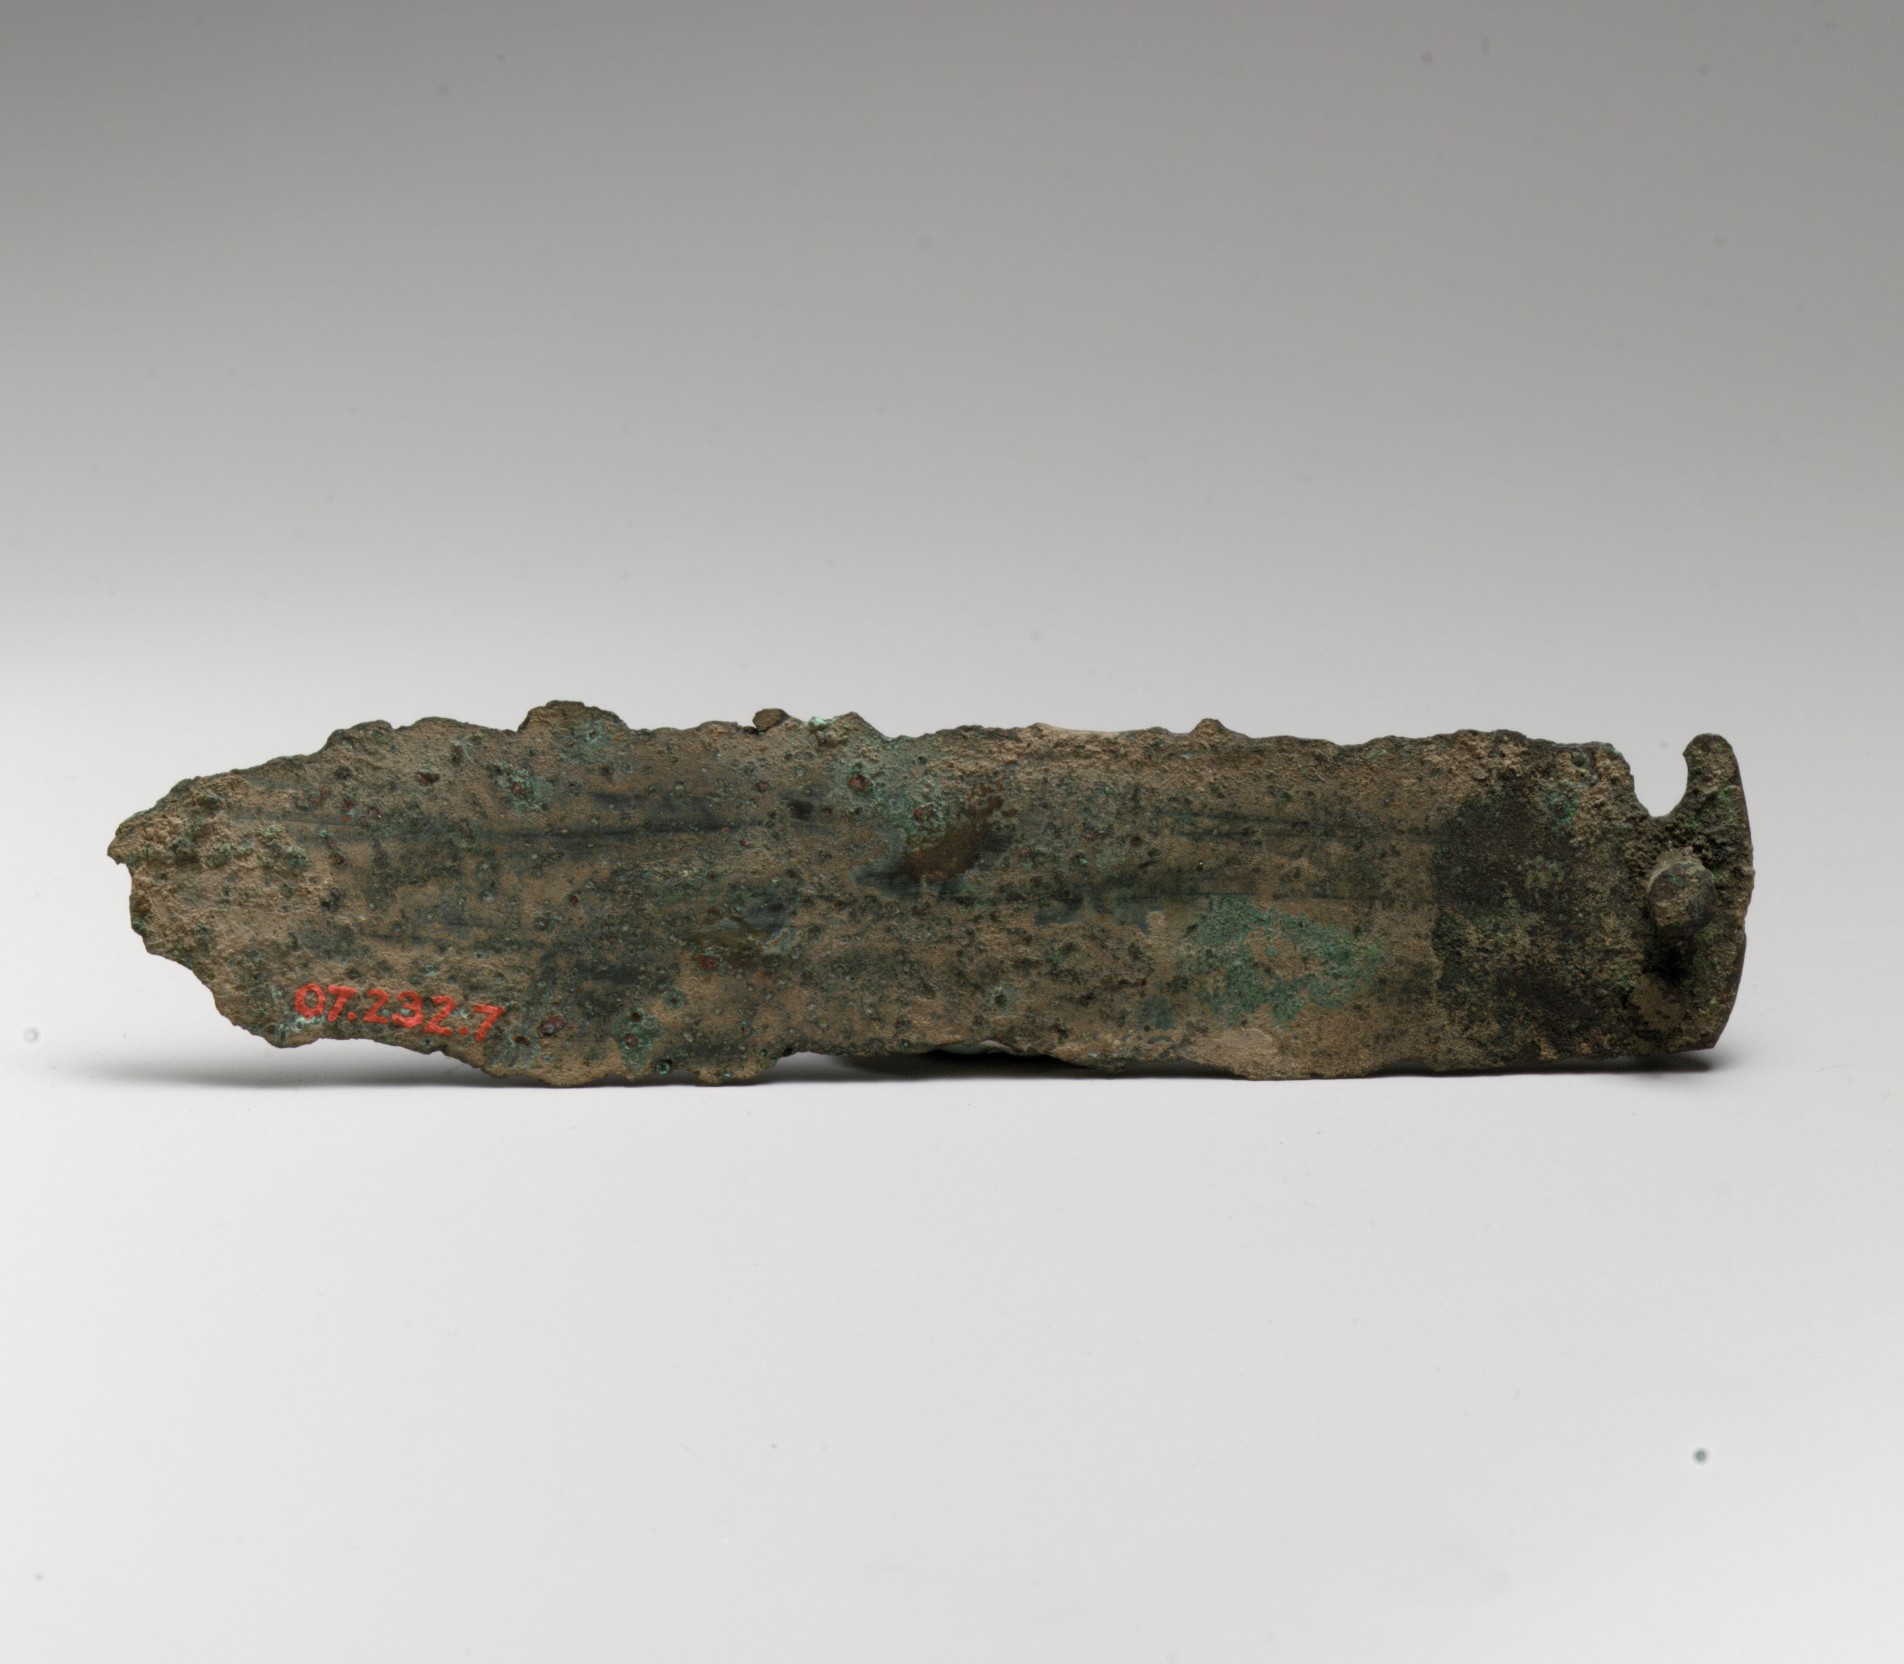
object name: knife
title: Bronze knife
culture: minoan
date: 1600-1450 BCE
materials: bronze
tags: knives